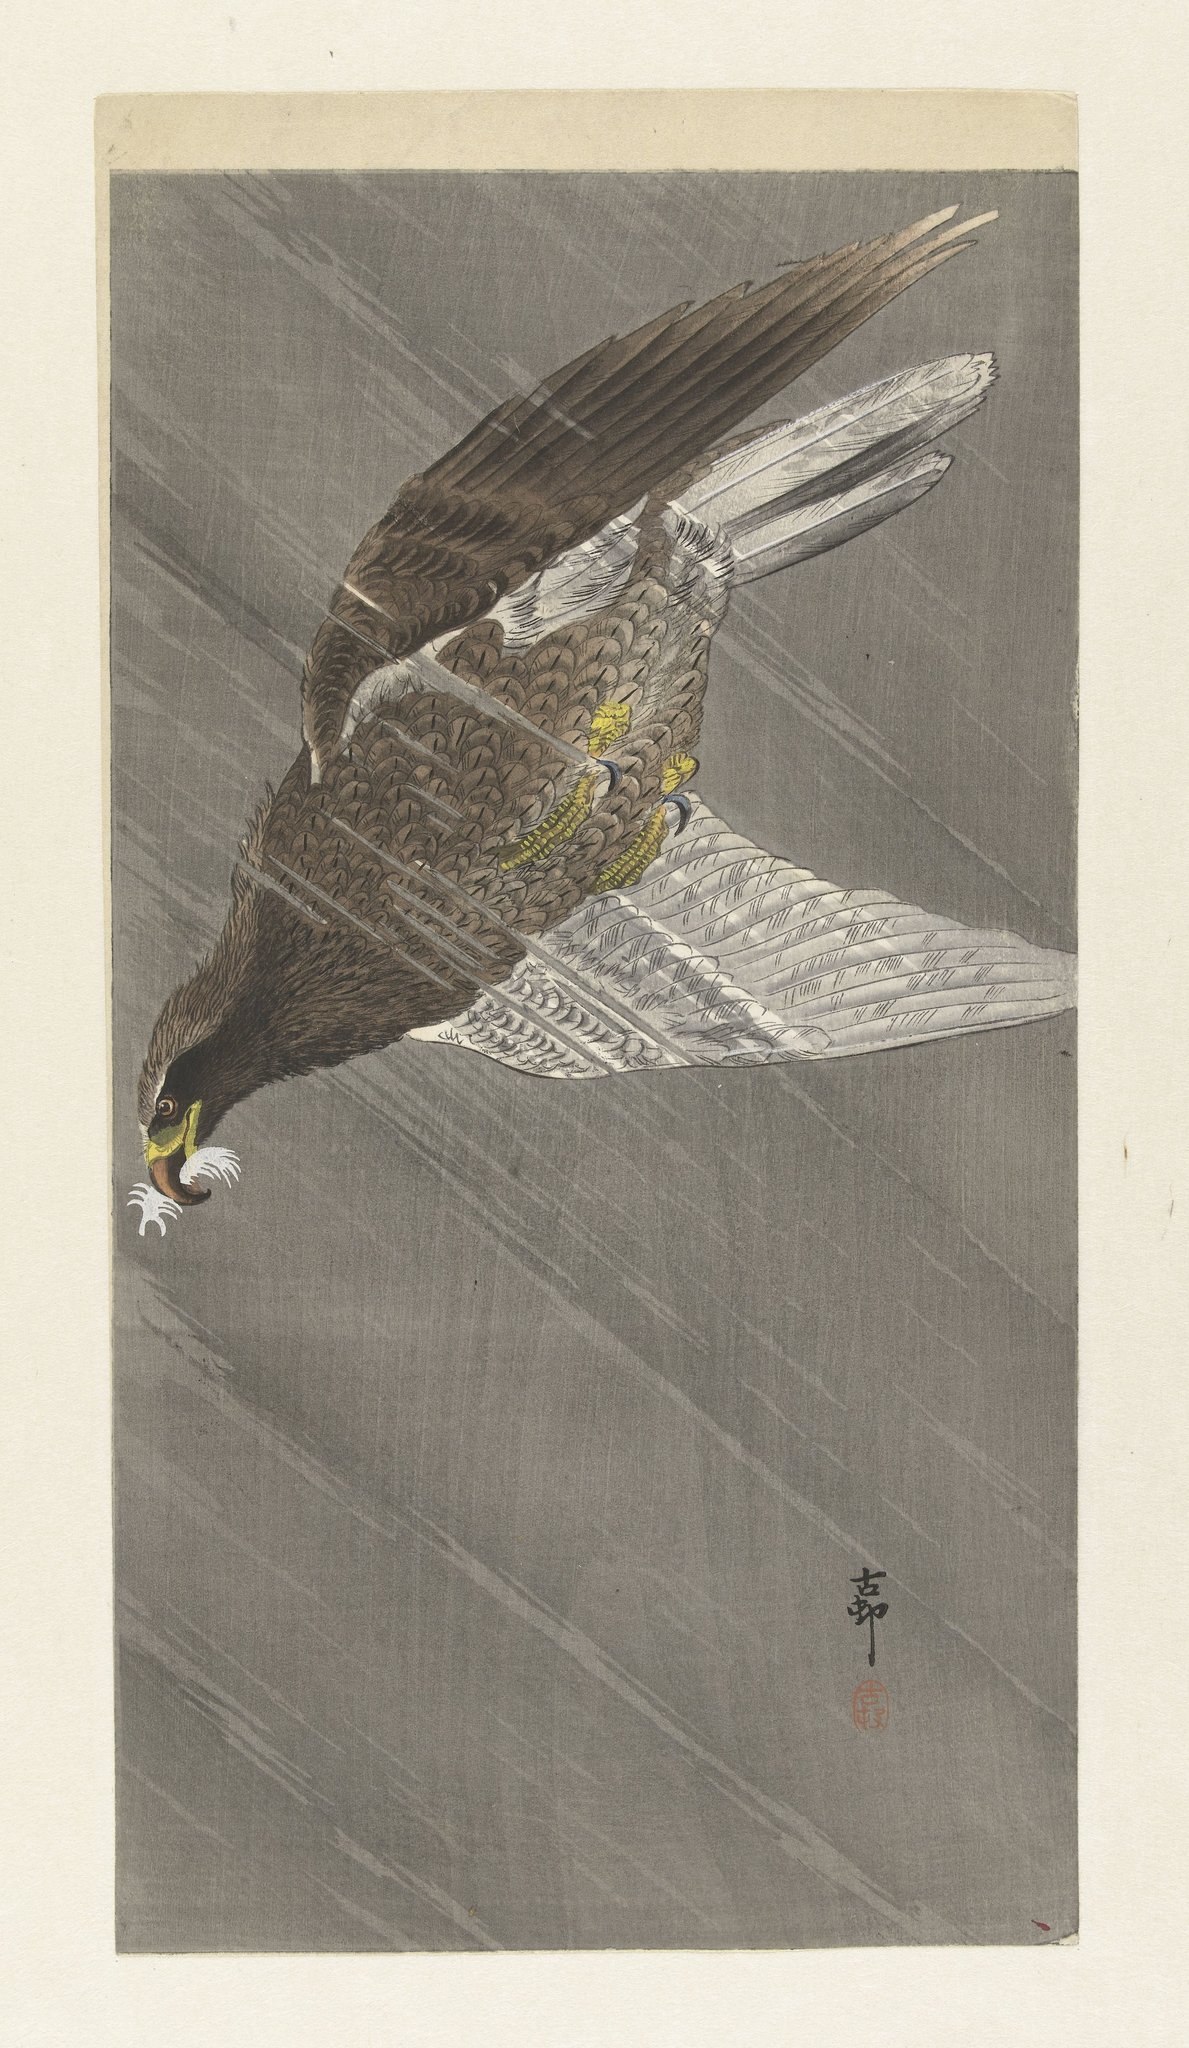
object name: print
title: Neerwaarts vliegende arend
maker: ohara koson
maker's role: print maker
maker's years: 1877-1945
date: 1900-1930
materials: paper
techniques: woodcut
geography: japan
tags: predatory birds: eagle, rain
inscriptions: collector's mark: Lugt 2228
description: Arend, neerwaarts vliegend in regen, een veertje in de bek